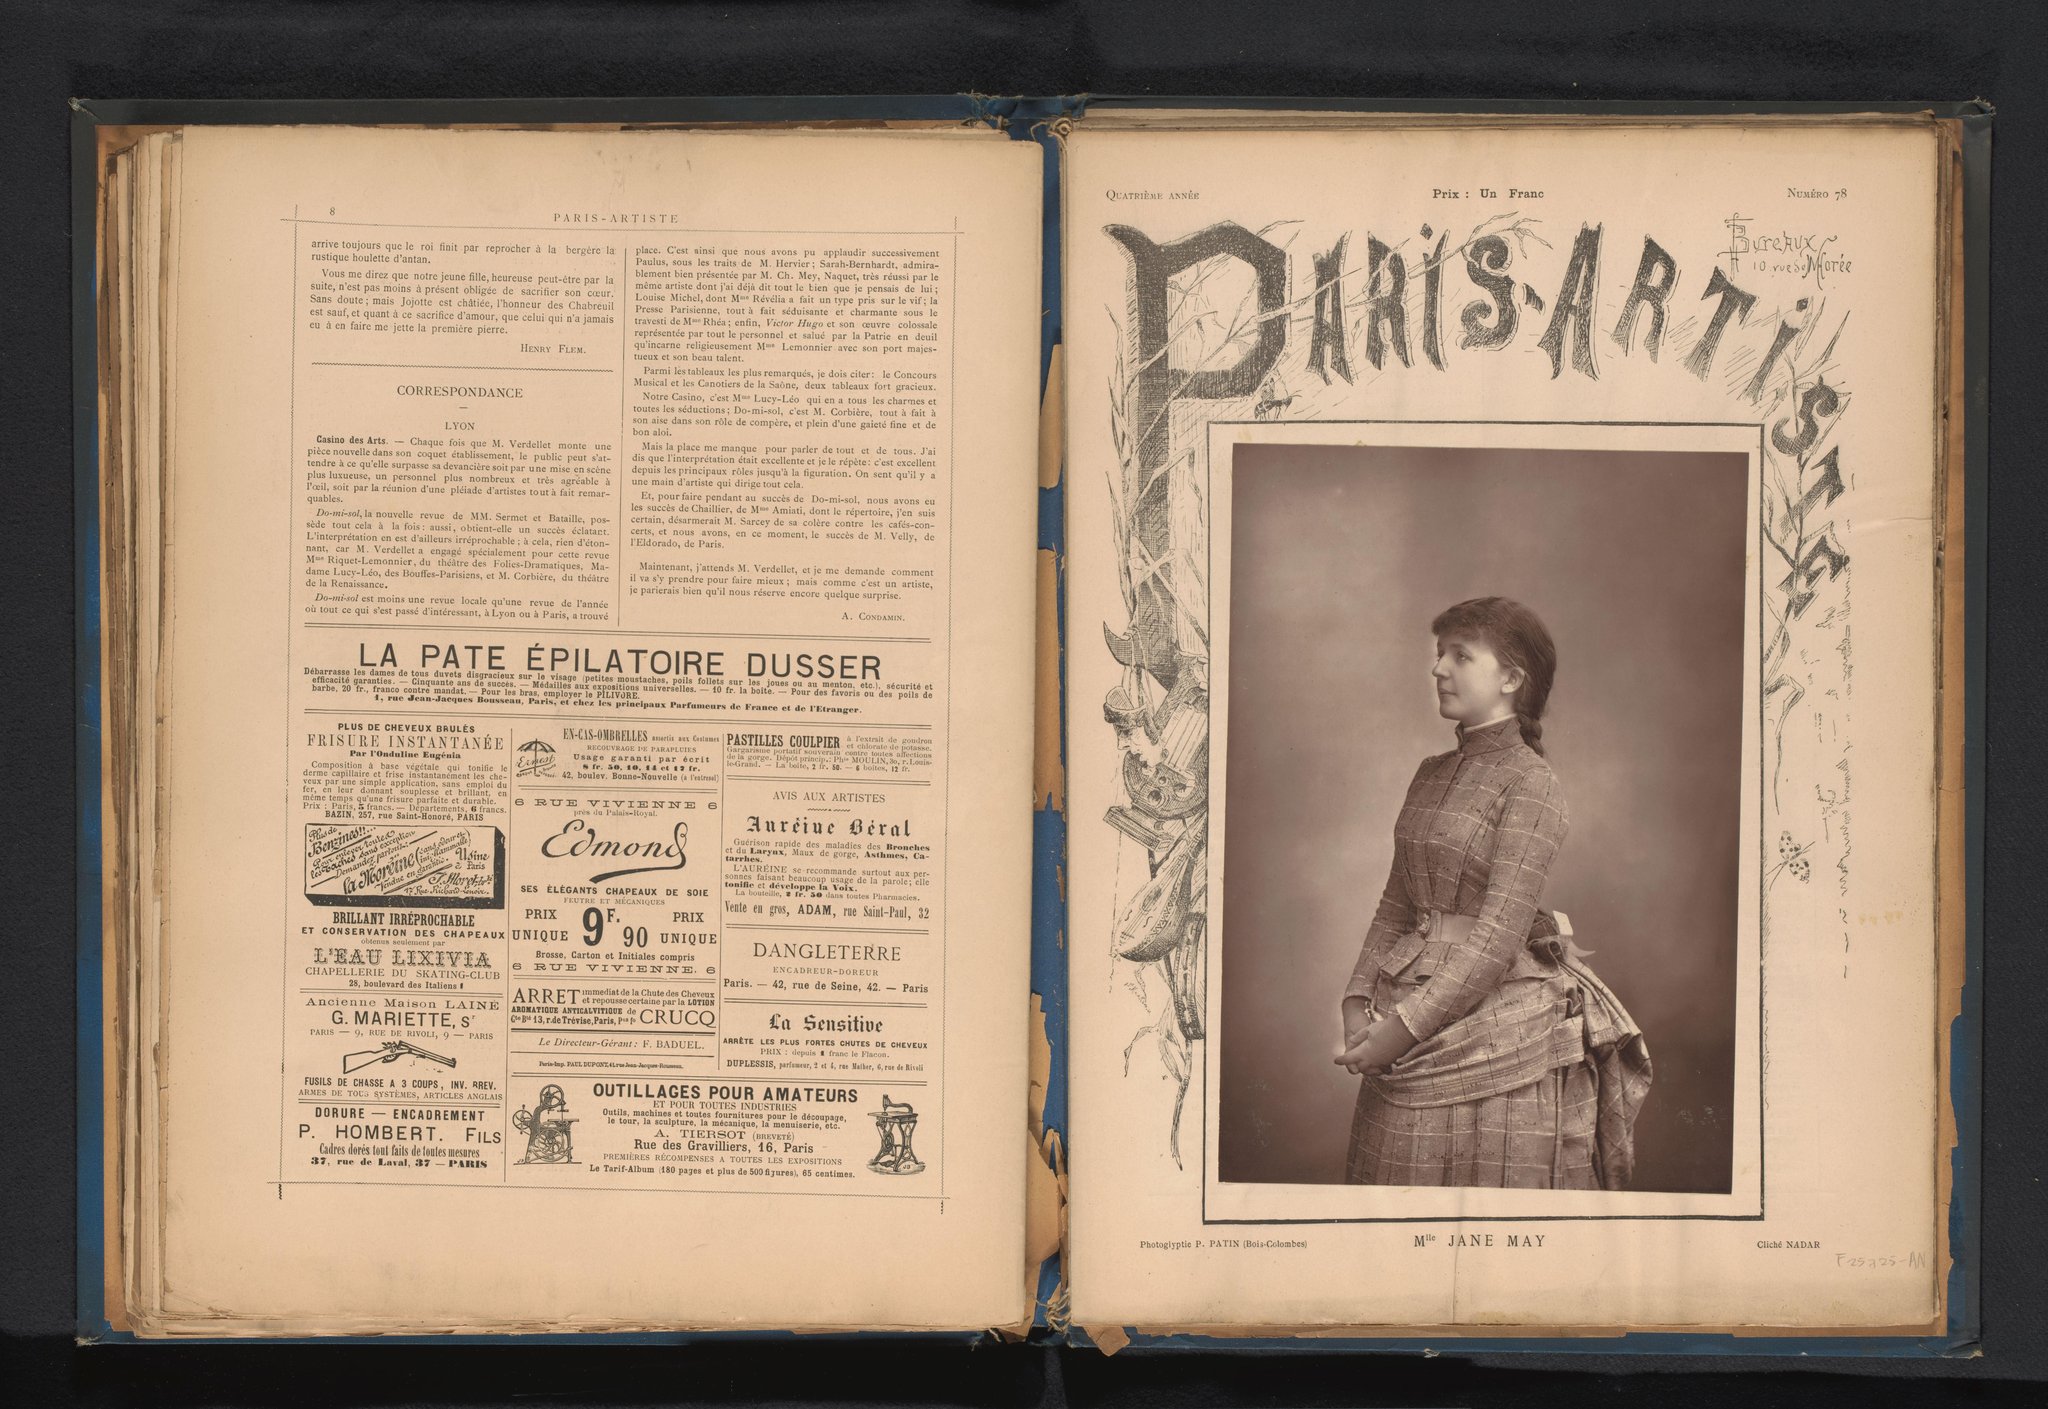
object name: page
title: Portret van Jane May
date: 1880-1886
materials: paper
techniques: woodburytype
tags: historical persons - bb - woman, portrait of actor, actress